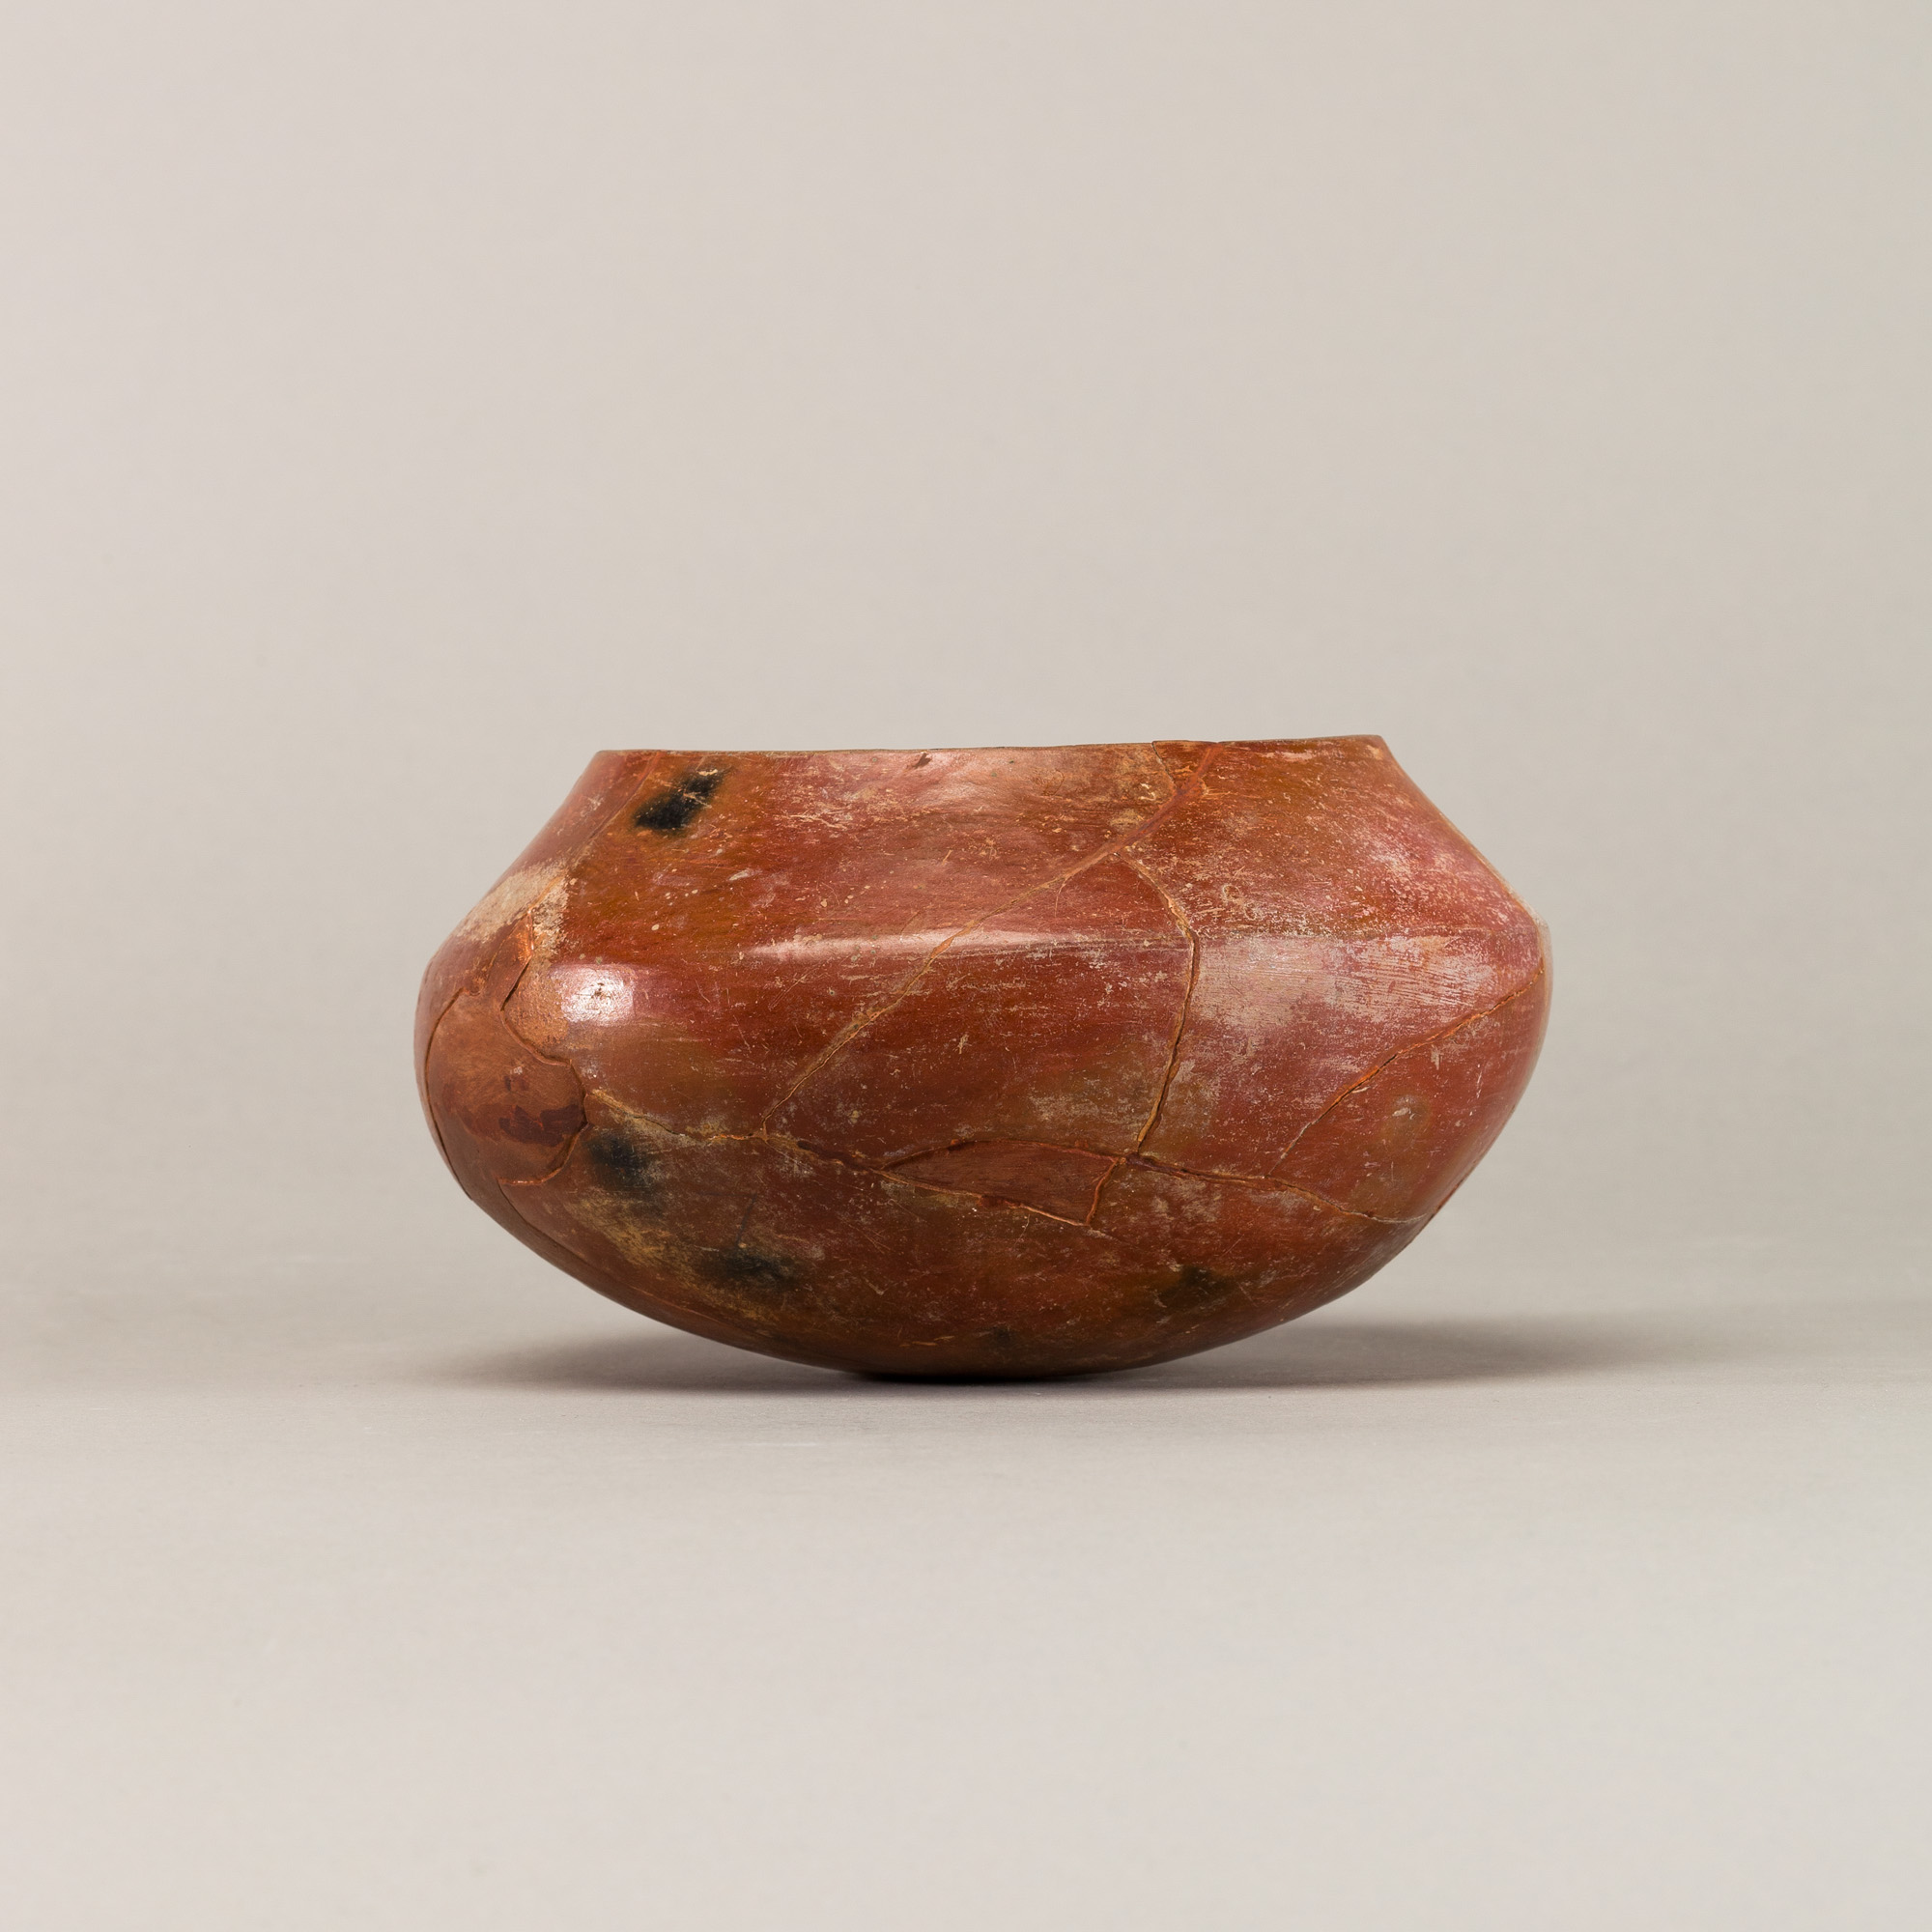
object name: bowl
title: Red polished ware bowl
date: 3850-2960 BCE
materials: pottery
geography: egypt